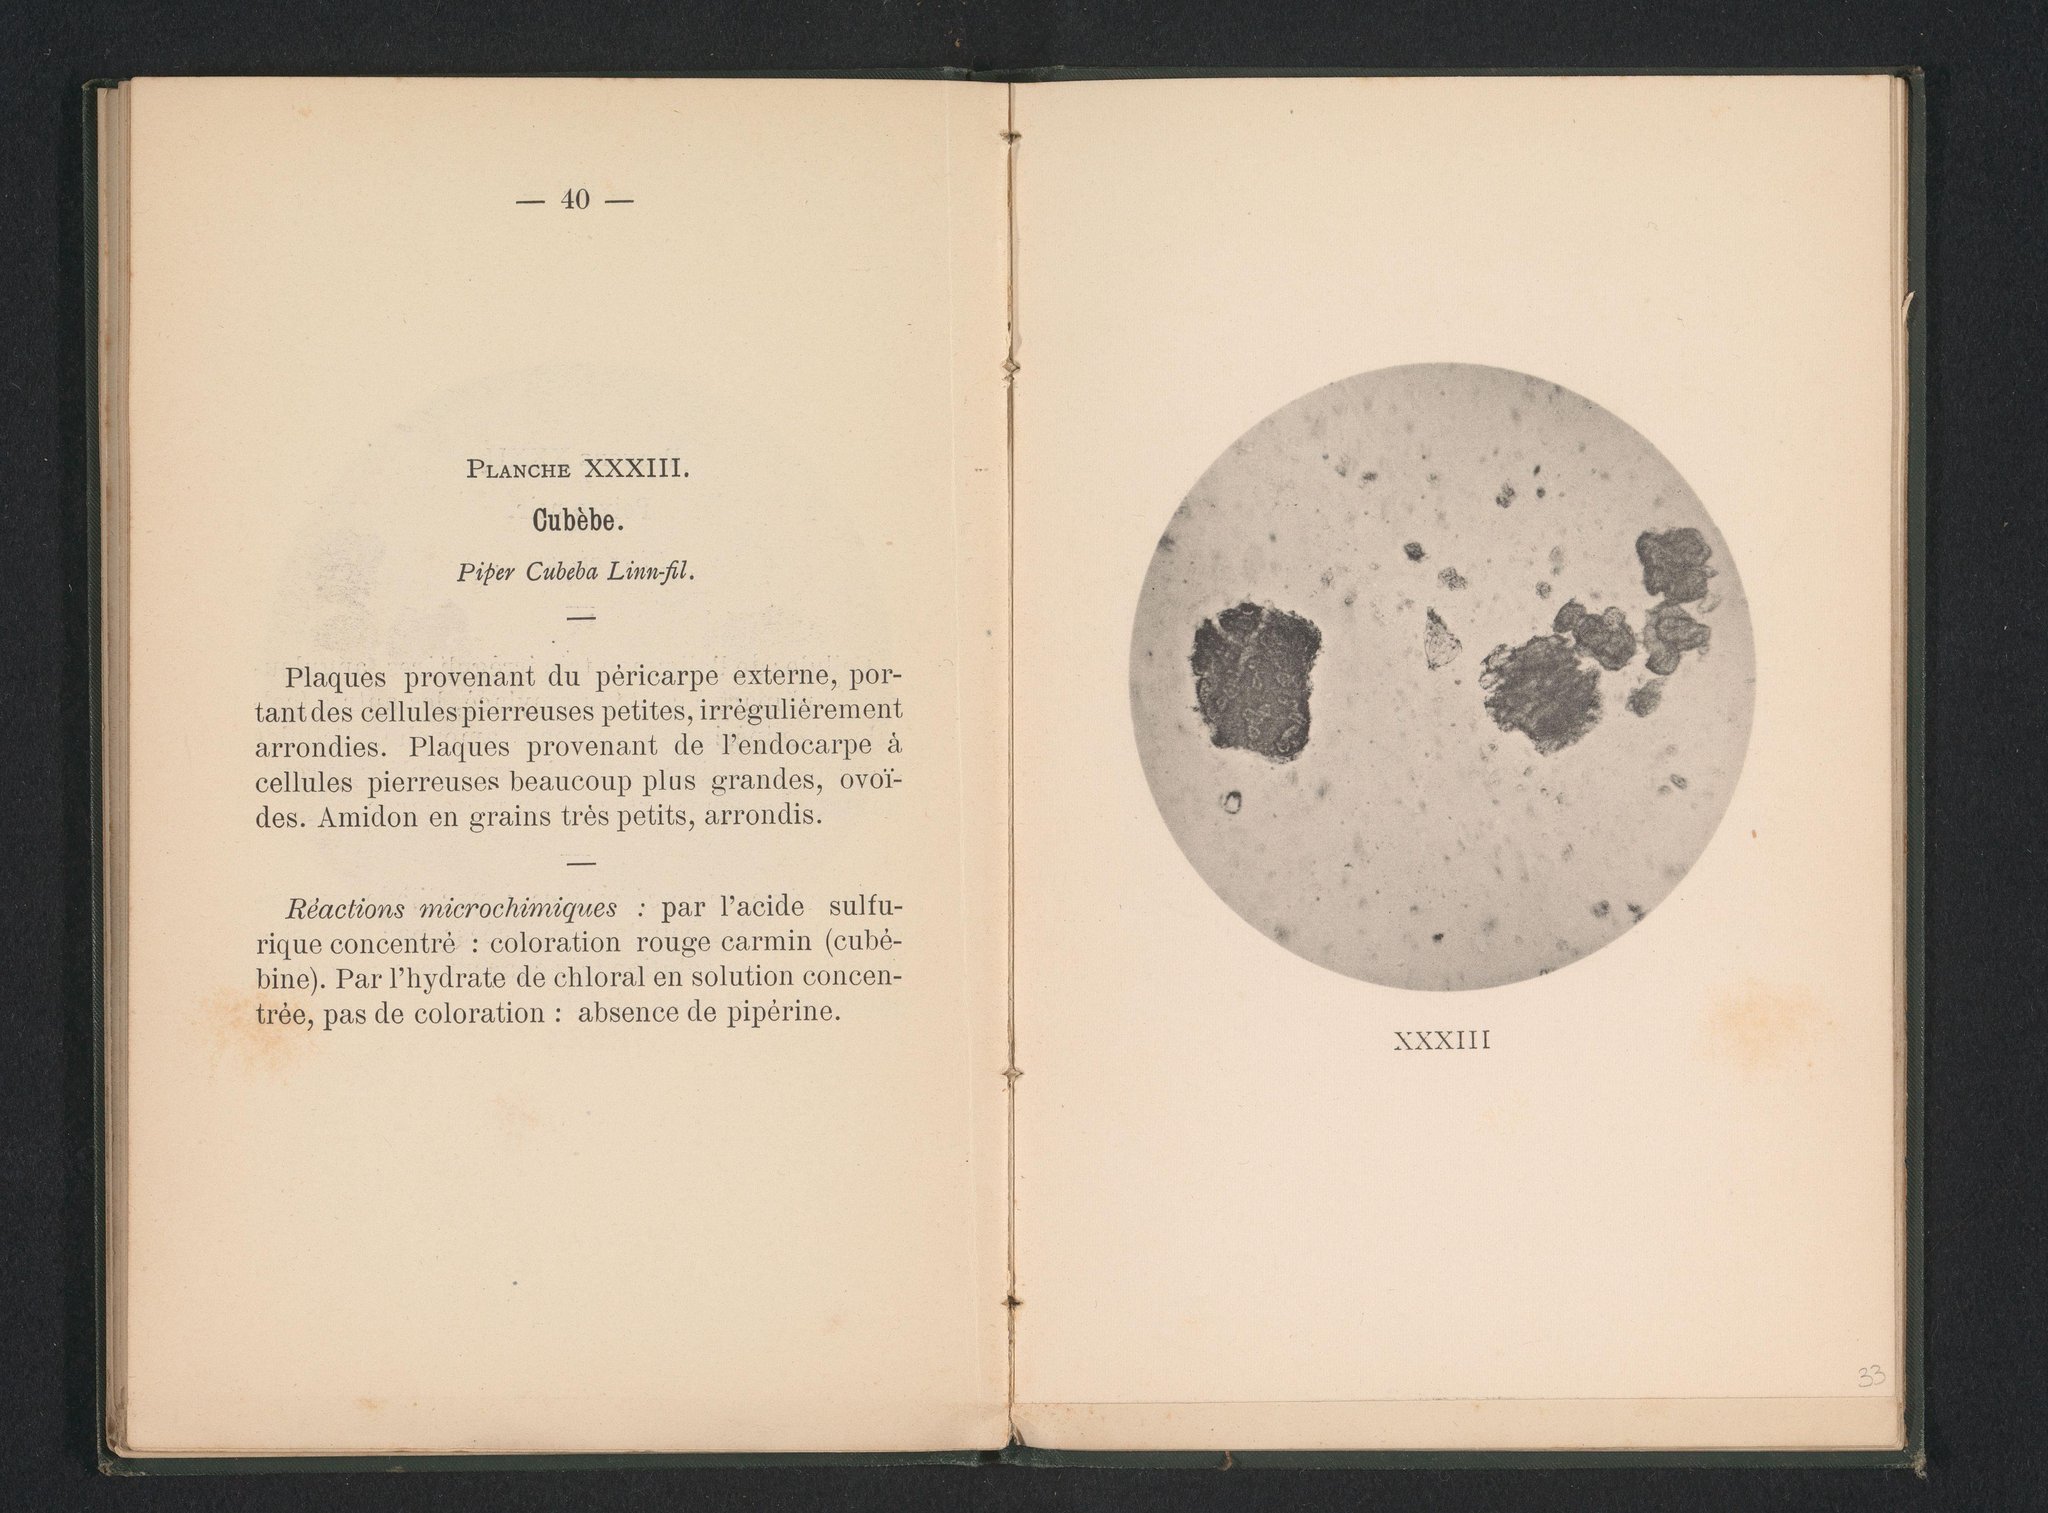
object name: photomechanical print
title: Microscopische weergave van staartpeper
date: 1891-1896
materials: paper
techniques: photograph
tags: microscope (+ scientific research)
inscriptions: number: ‘XXXIII’